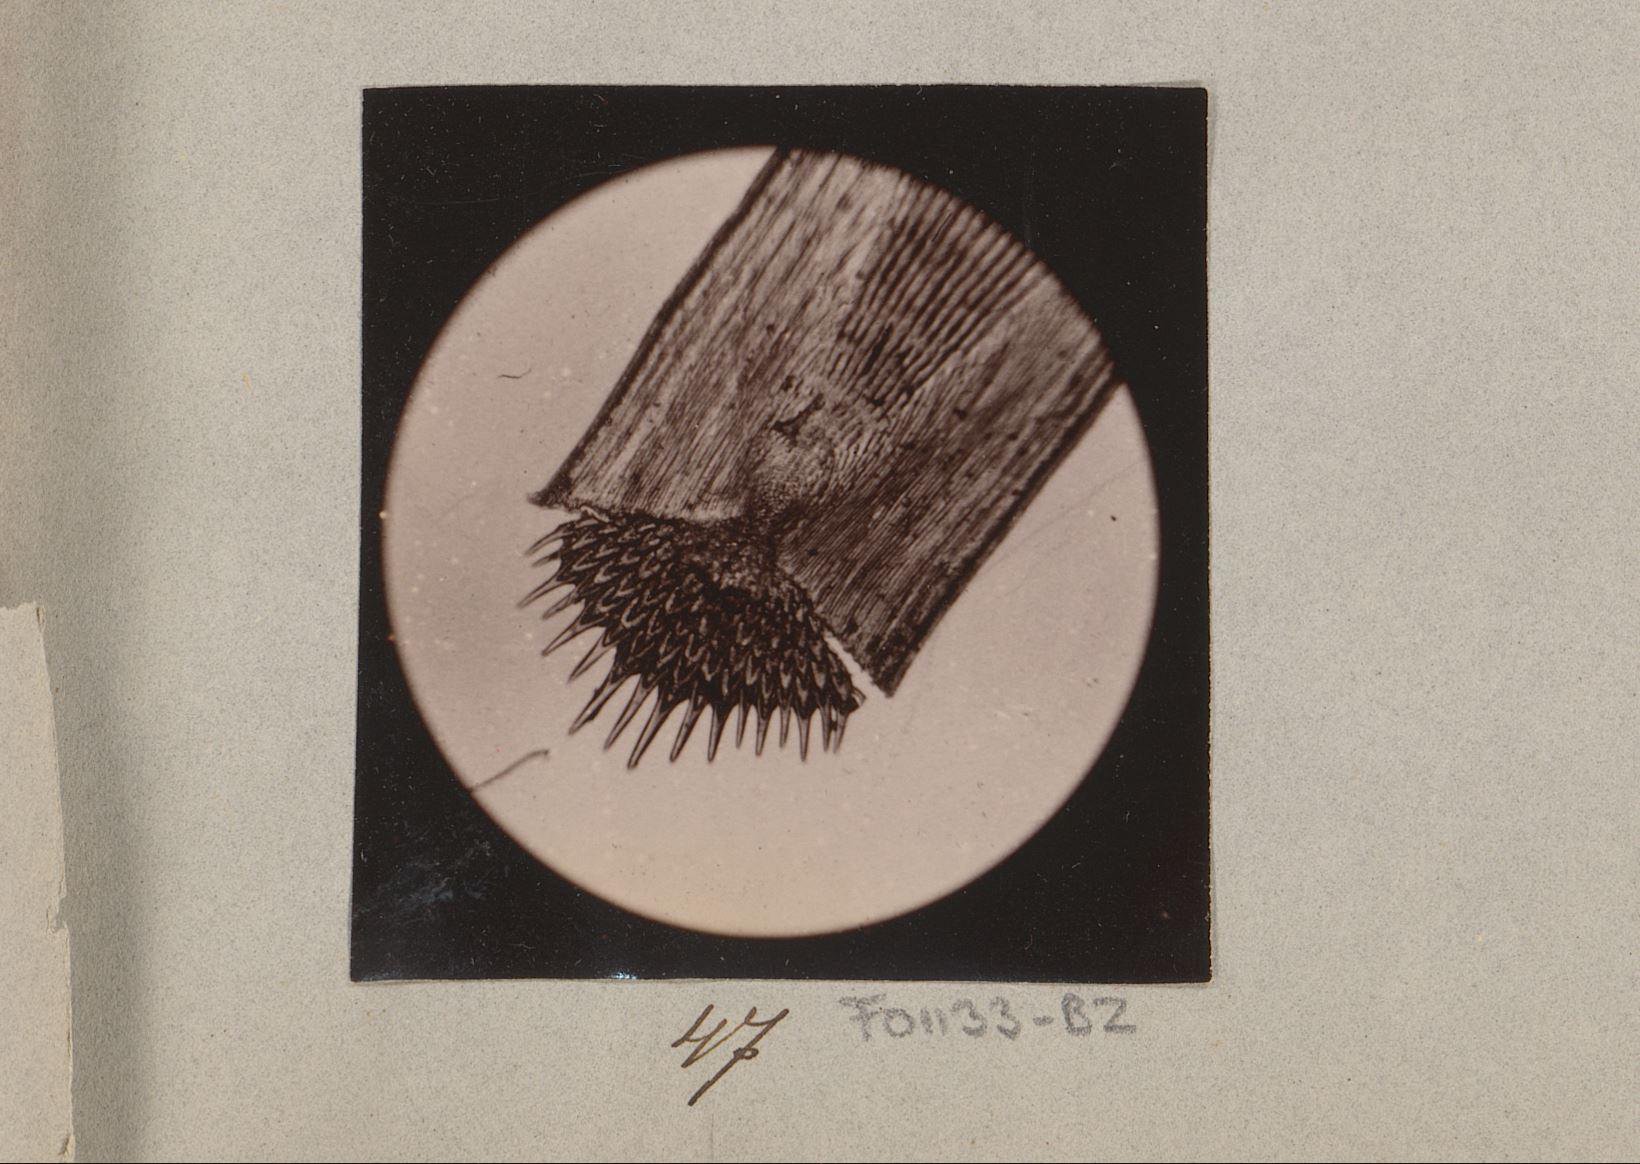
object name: album leaf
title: Microscopische opname van een tongschub, 25 keer vergroot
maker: marinus pieter filbri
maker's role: instrument maker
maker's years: 1852-1917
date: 1887-1888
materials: paper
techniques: albumen print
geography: netherlands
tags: fishes, netherlands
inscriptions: number: ‘47’, inscription: ‘No. 47. Benaming Tongschub (onderdeel), 25 x vergroot, pose 4 m., Bewerking idem’